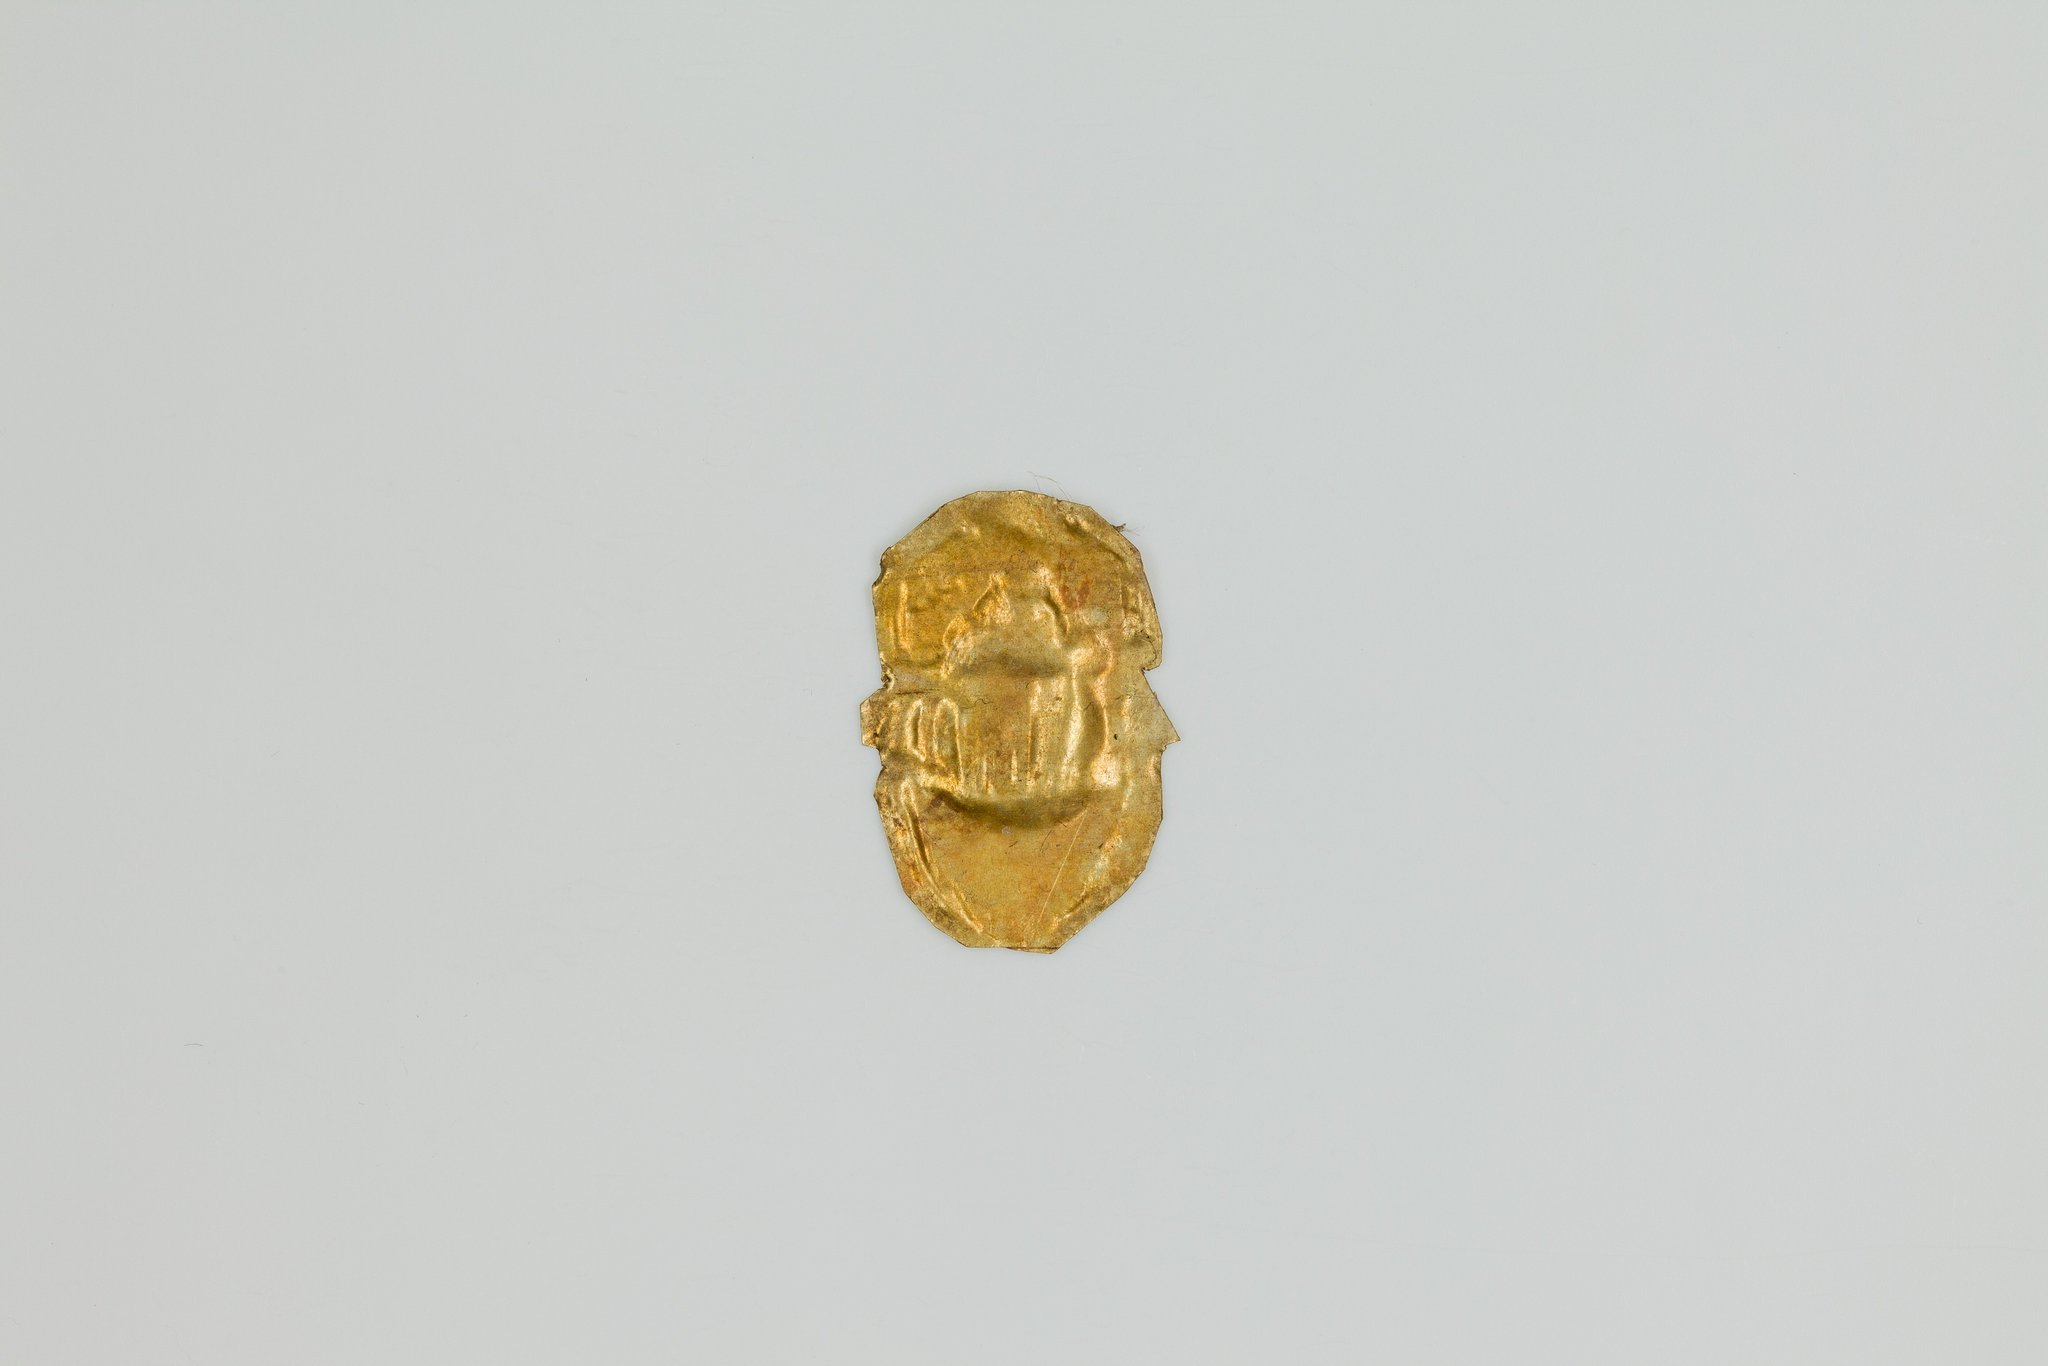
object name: amulet, scarab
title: Scarab amulet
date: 664-380 BCE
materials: gold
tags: scarabs